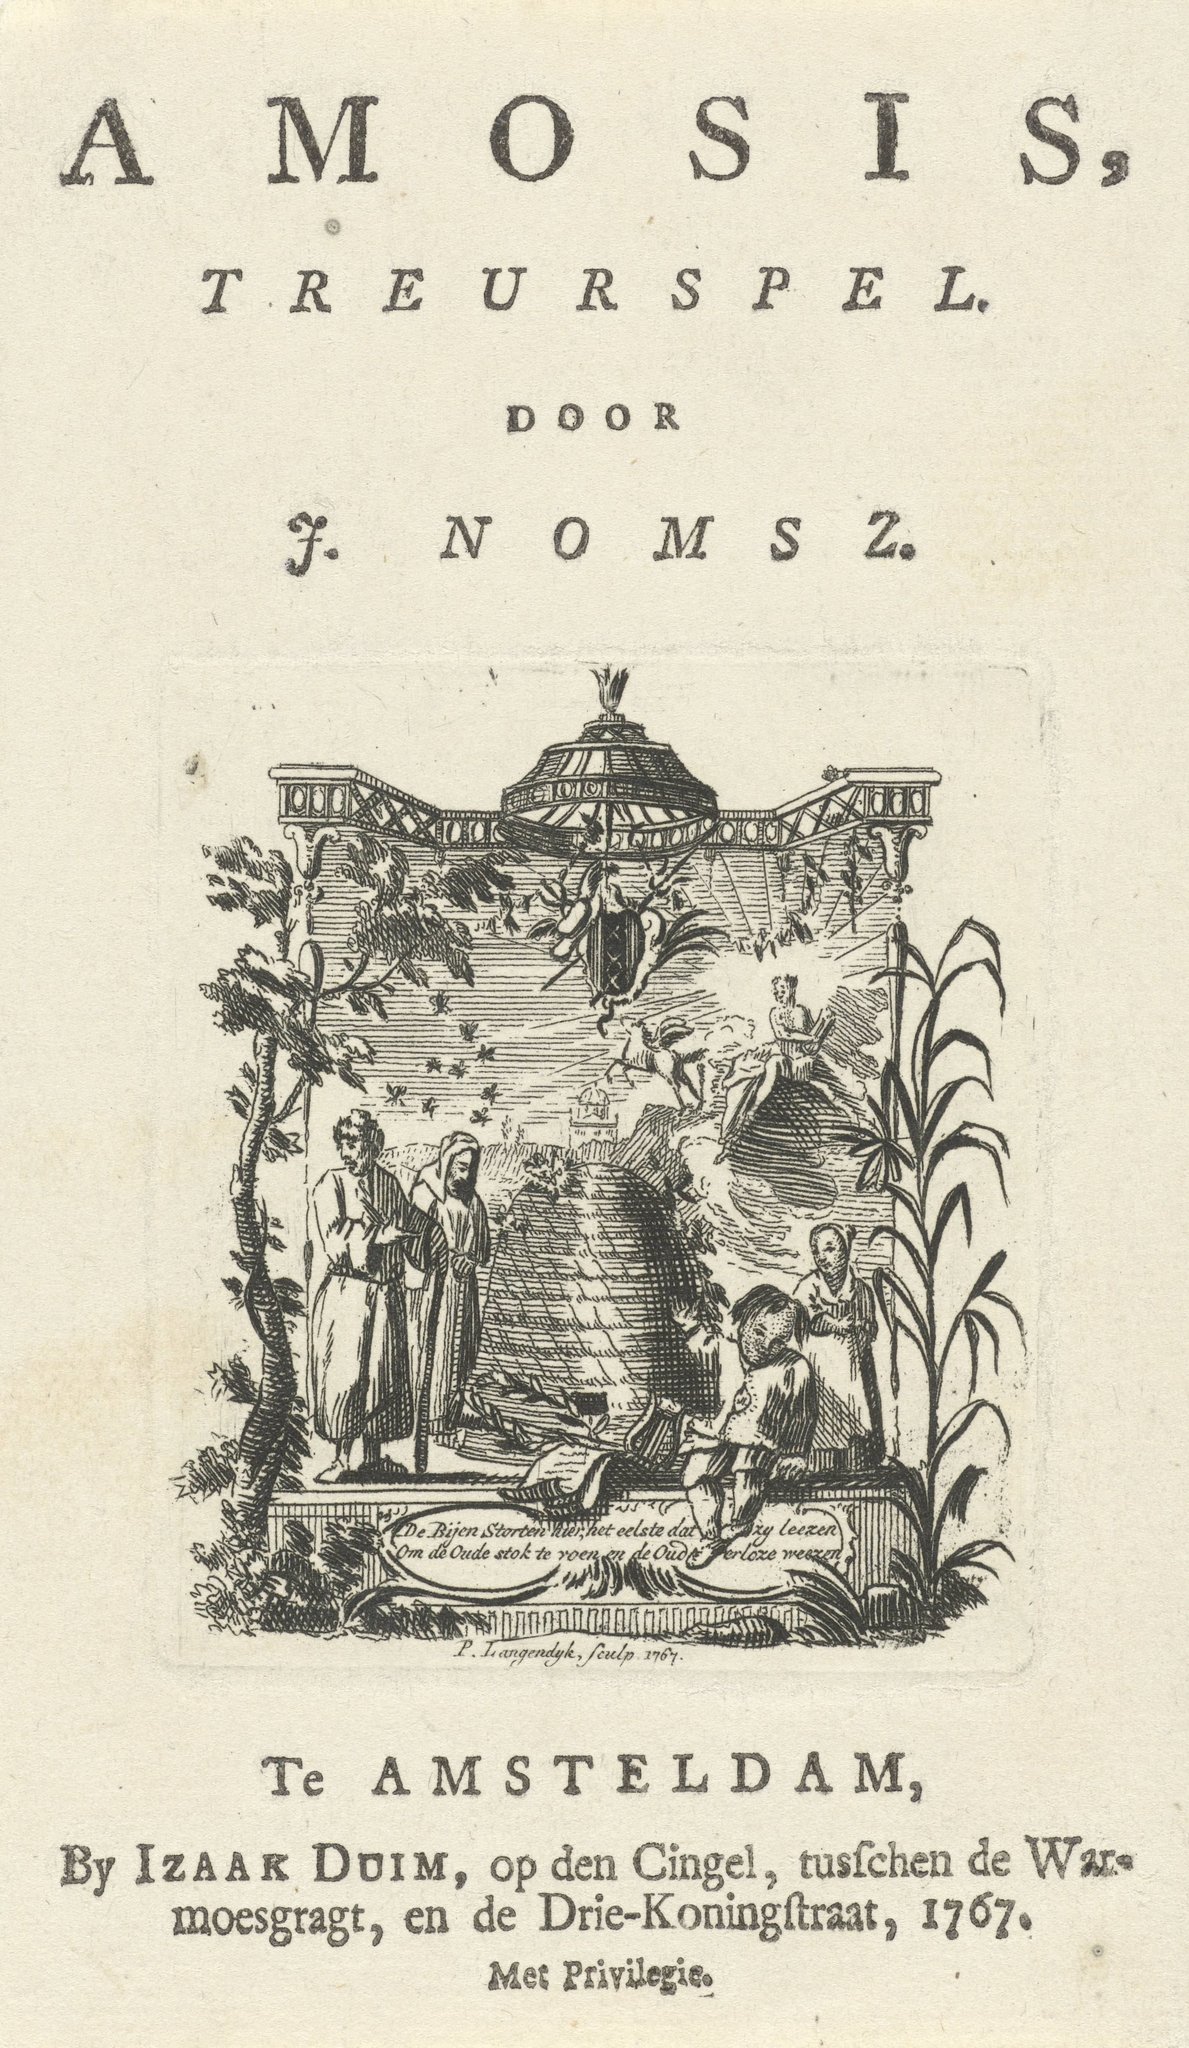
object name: titelblad, titelpagina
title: Figuren rond een bijenkorf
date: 1767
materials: paper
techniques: letterpress printing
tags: coat of arms (as symbol of the state, etc.) (+ city; municipal), pegasus, the winged horse, bee-hive, apollo playing the lyre, apollo citharoedus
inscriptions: collector's mark: Lugt 2228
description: Op een toneel staan figuren rond een bijenkorf, symbool van de Amsterdamse schouwburg. Op de achtergrond vliegt het gevleugelde paard Pegasus en bespeelt Apollo op de berg Parnassus de lier. De voorstelling is omlijst met gebladerte en takken, bovenin prijkt het wapen van de stad Amsterdam. Op een rand onder de bijenkorf staat een tweeregelig vers in het Nederlands.